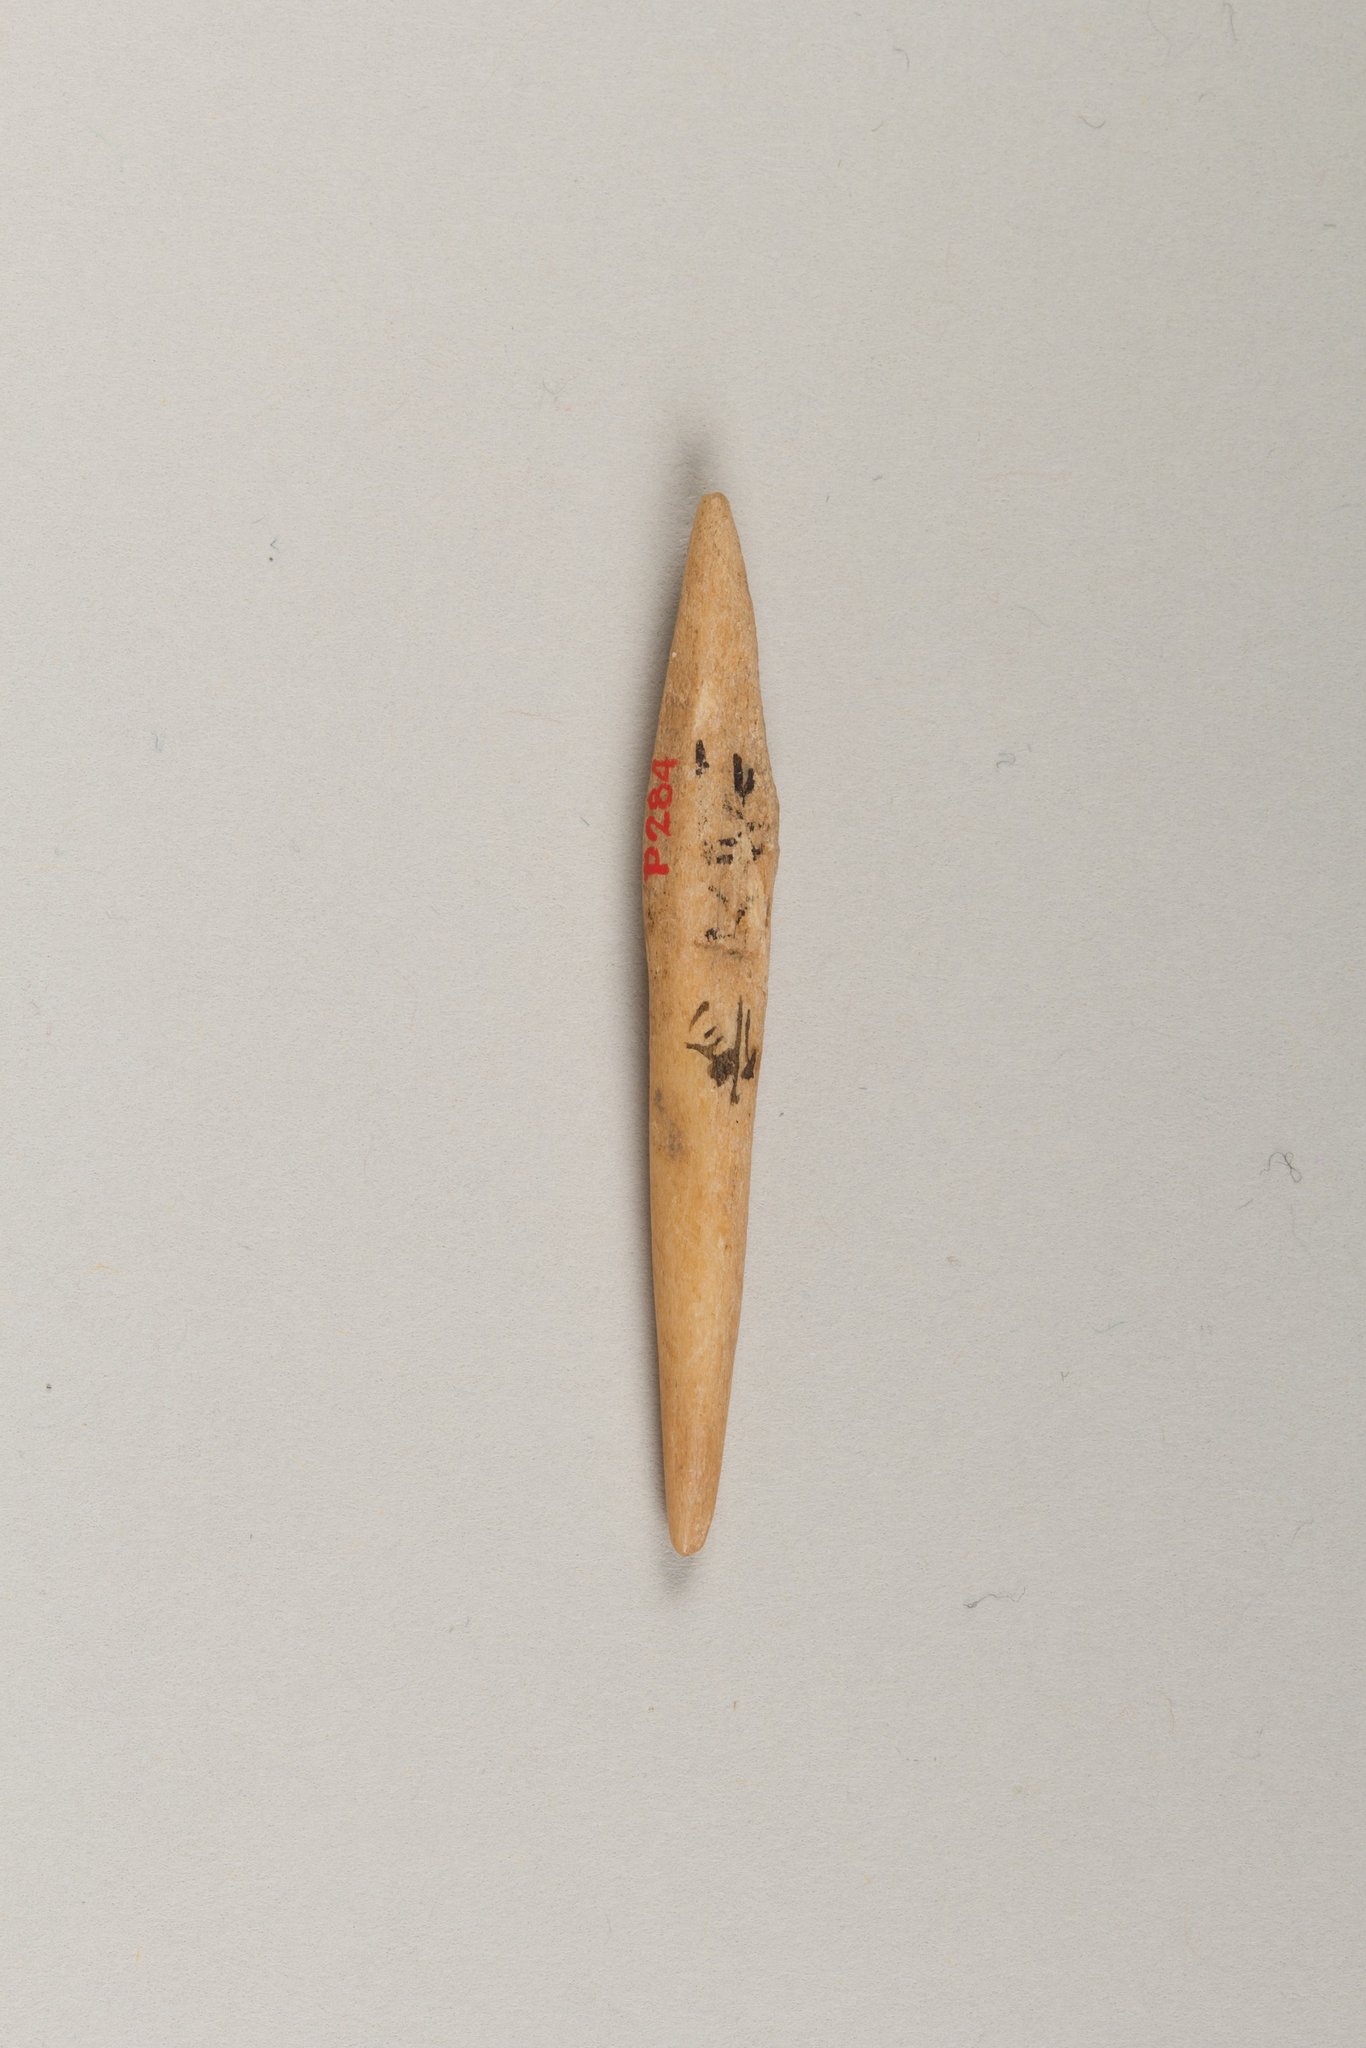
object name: harpoon head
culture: japanese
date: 1000-300 BCE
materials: bone